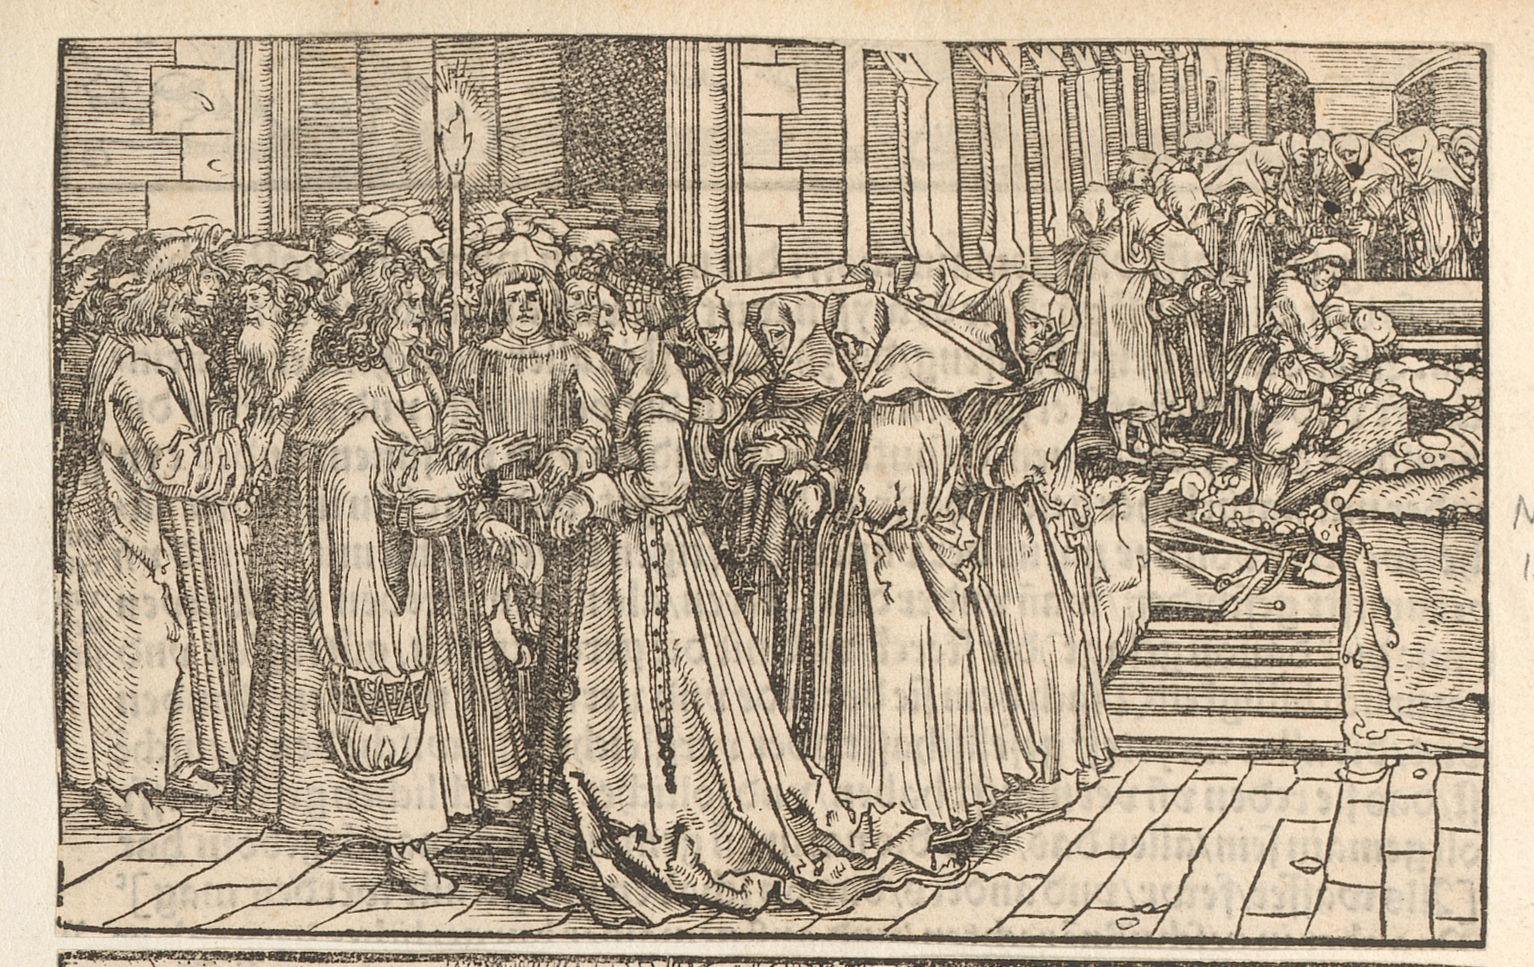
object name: print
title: Huwelijk van een man en zijn tweede vrouw terwijl zijn eerste vrouw wordt begraven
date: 1514-1532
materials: paper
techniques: letterpress printing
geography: augsburg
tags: second marriage (of widow or widower), marriage, married couple, 'matrimonium'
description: Deze prent is gebruikt in: Petrarca, Francesco. Von der Artzney bayder Glück, des guten und widerwertigen: unnd weß sich ain yeder inn Gelück und Unglück halten sol (...). Augsburg: Heinrich Steiner, 1532. Deze uitgave is ook bekend onder de titel 'Trostspiegel in Glück und Unglück'. Deze prent is ook gebruikt in: Cicero, Marcus Tulius. Officia M.T.C. Ein Buch so Marcus Tullius Cicero der Römer zu seynem (...). [Vertaald uit het Latijn door] Johann von Schwarzenberg. Augsburg: Heinrich Steiner, 1531.